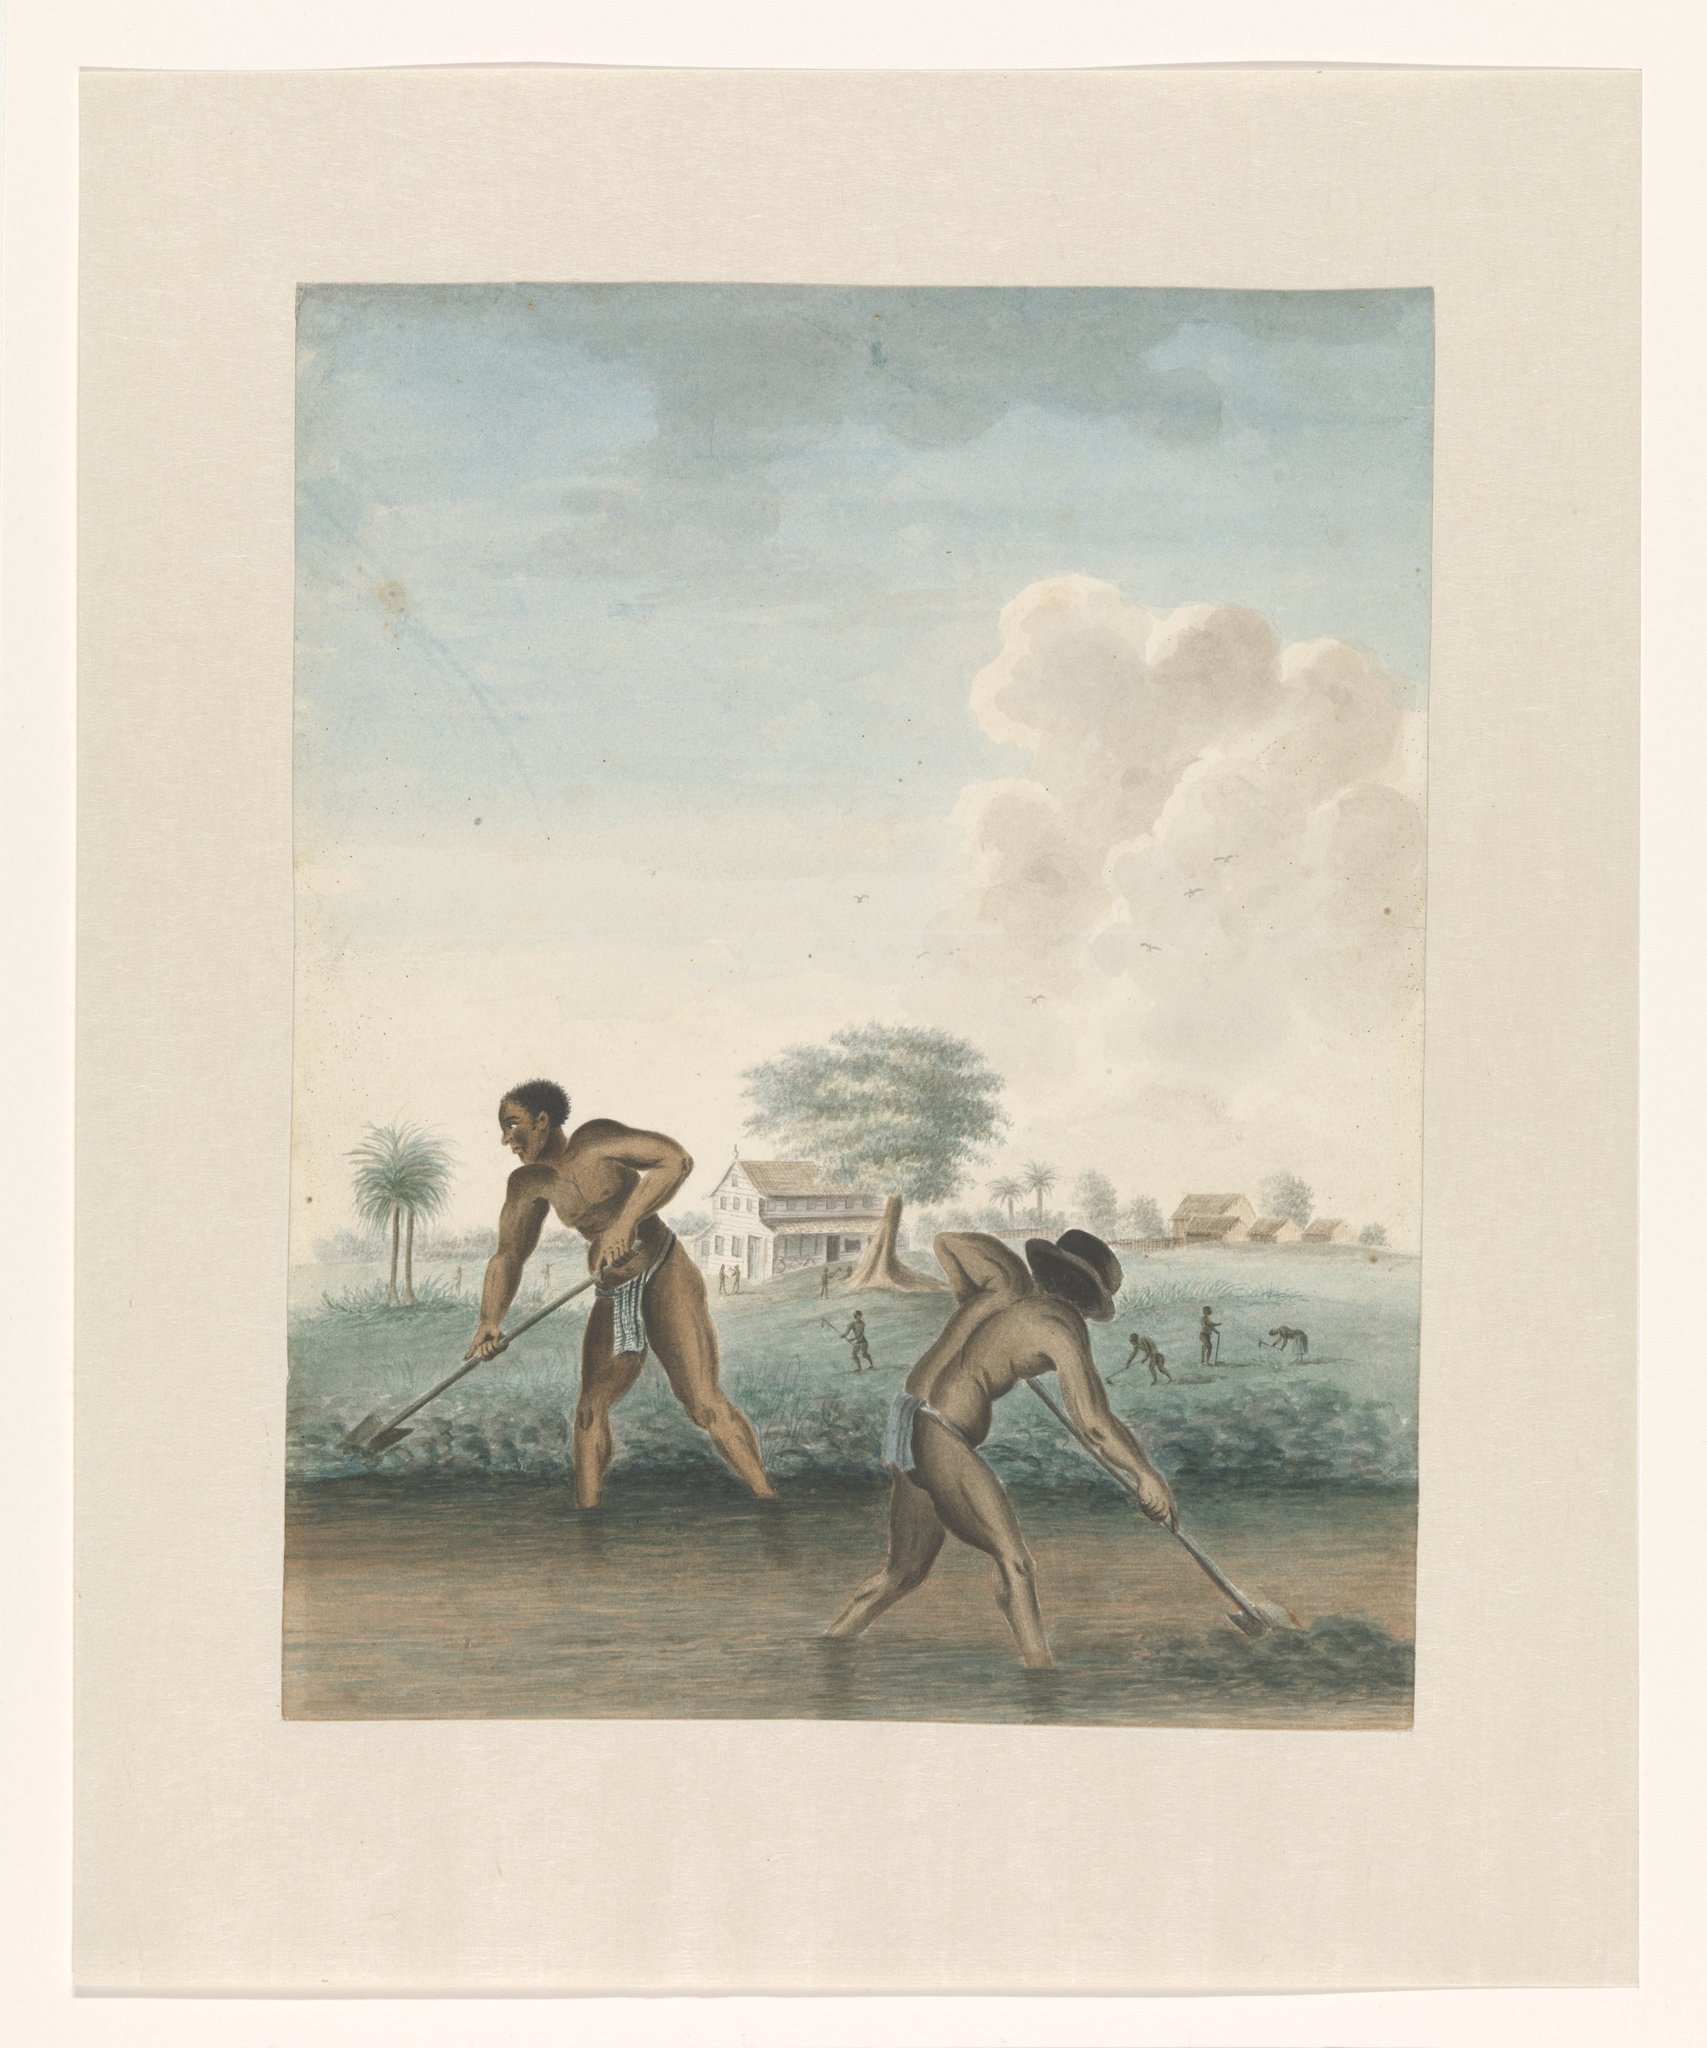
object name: watercolor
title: Enslaved Men Digging Trenches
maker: Anonymous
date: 1850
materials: paper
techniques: aquarelle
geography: paramaribo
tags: plantation, slavery; serfs and enslaved persons, suriname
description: Suriname consists largely of impenetrable forests. In order to establish a plantation, first a stretch of forest had to be reclaimed and trenches for drainage and transport dug. In the scorching heat, men were forced to dig broad canals and narrow trenches using nothing more than a shovel. This was incredibly hard work, which is still cited in the oral traditions as one of the principal reasons for fleeing a plantation.